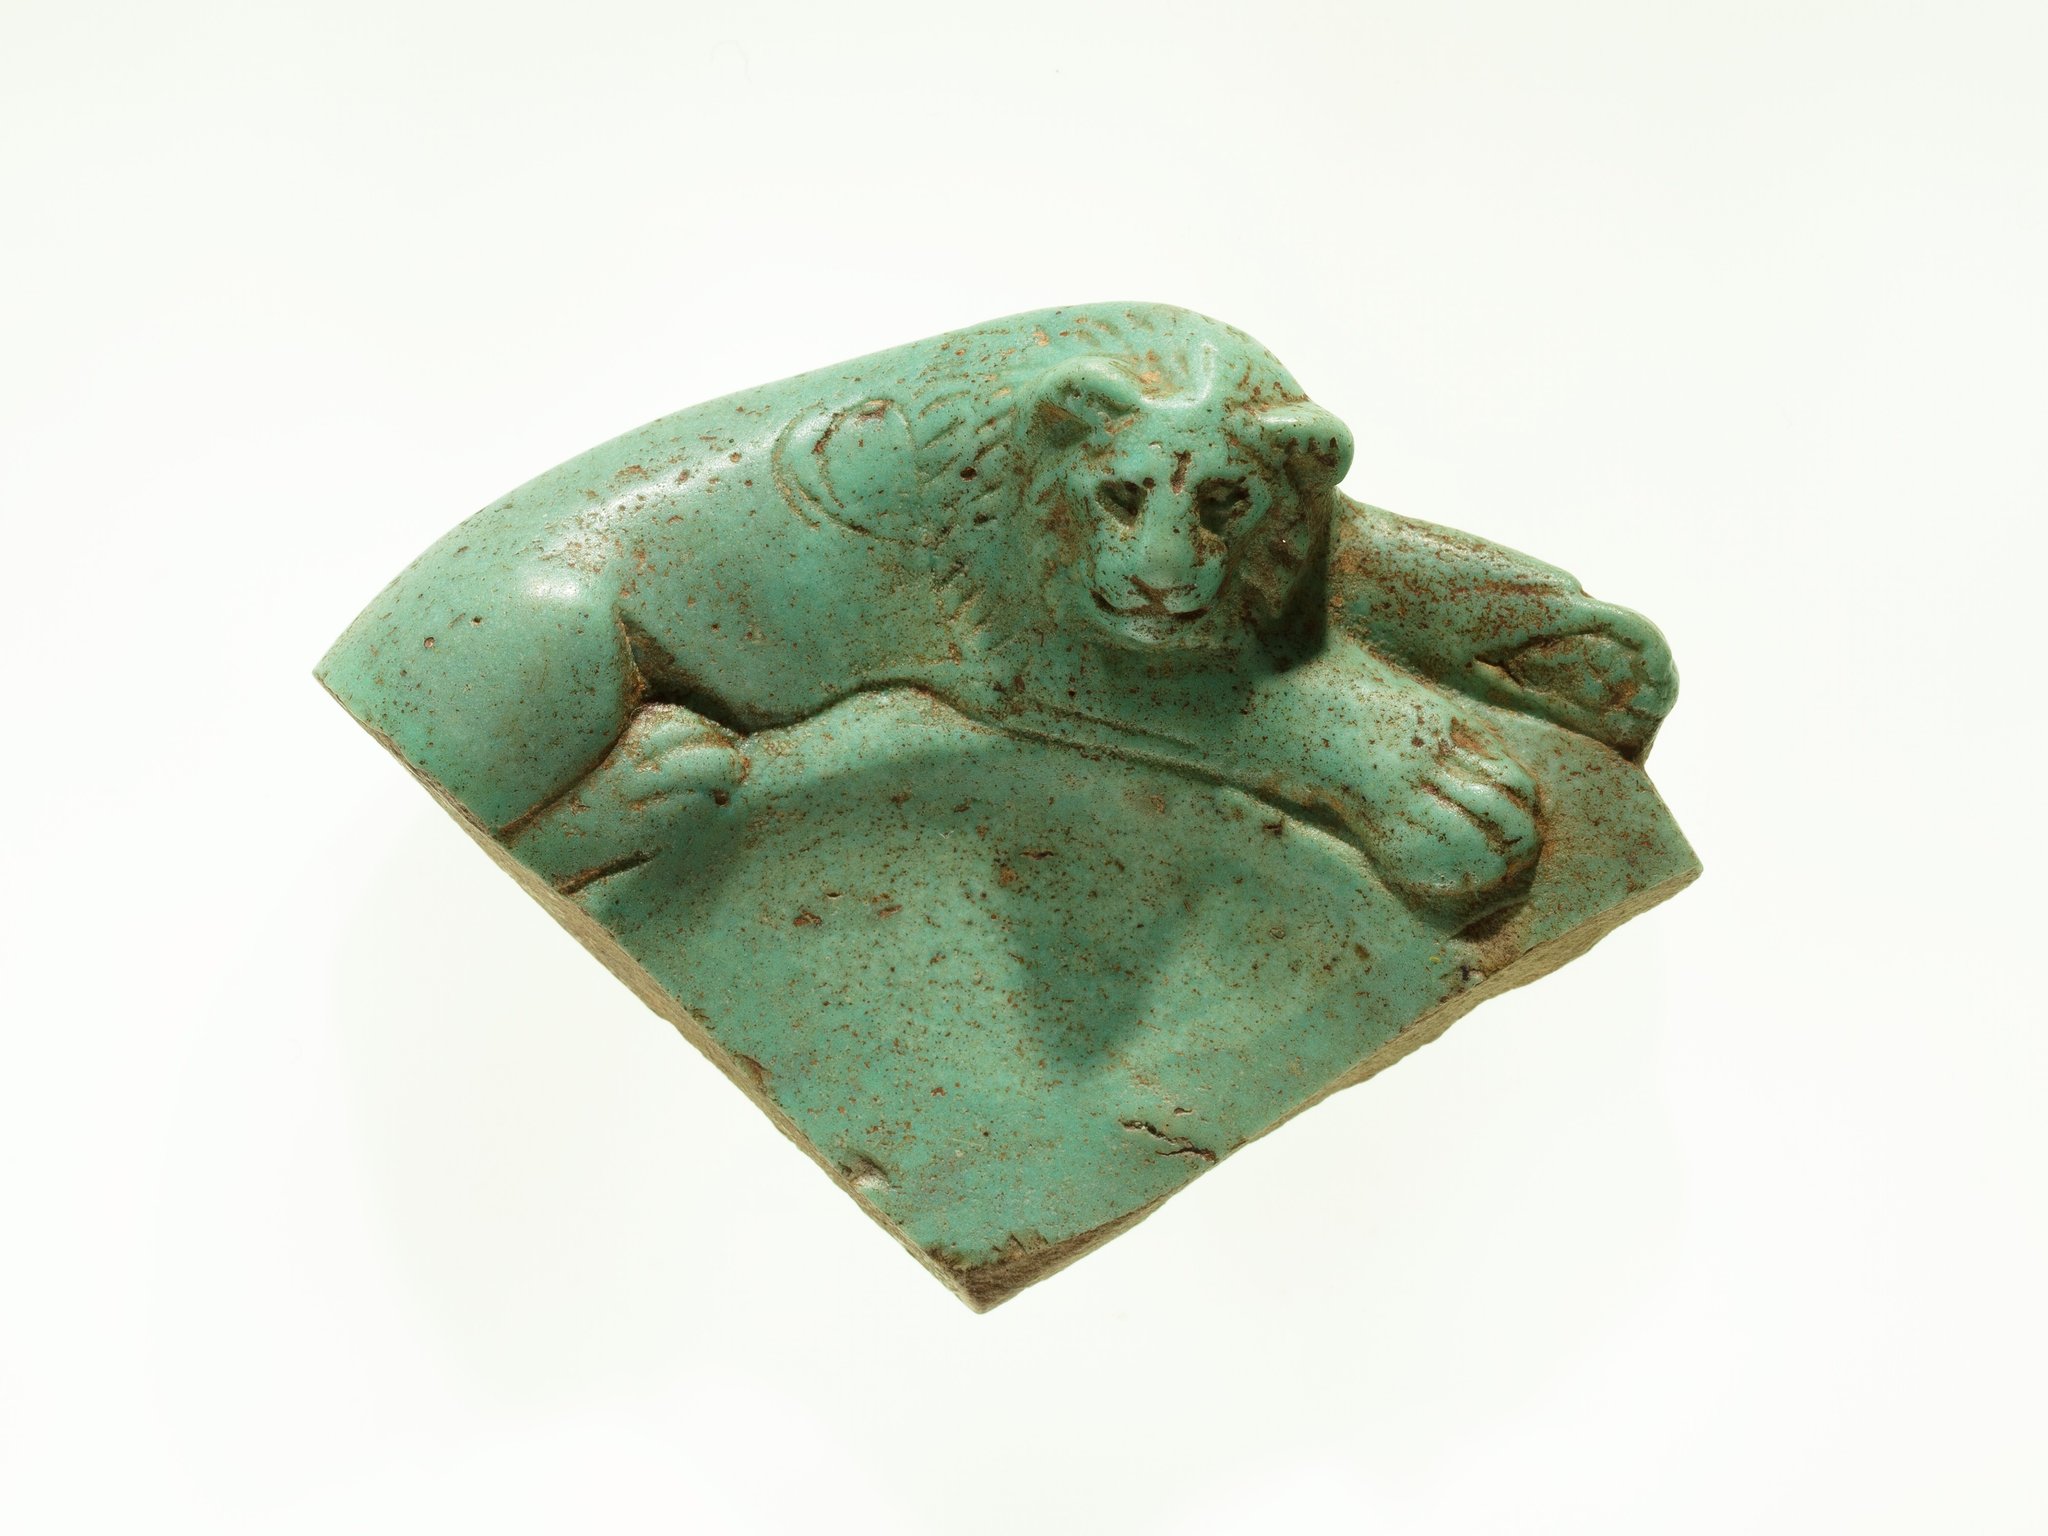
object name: vessel fragment, lion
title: Fragment of a dish with a lion reclining on the rim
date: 664-332 BCE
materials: faience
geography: egypt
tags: lions